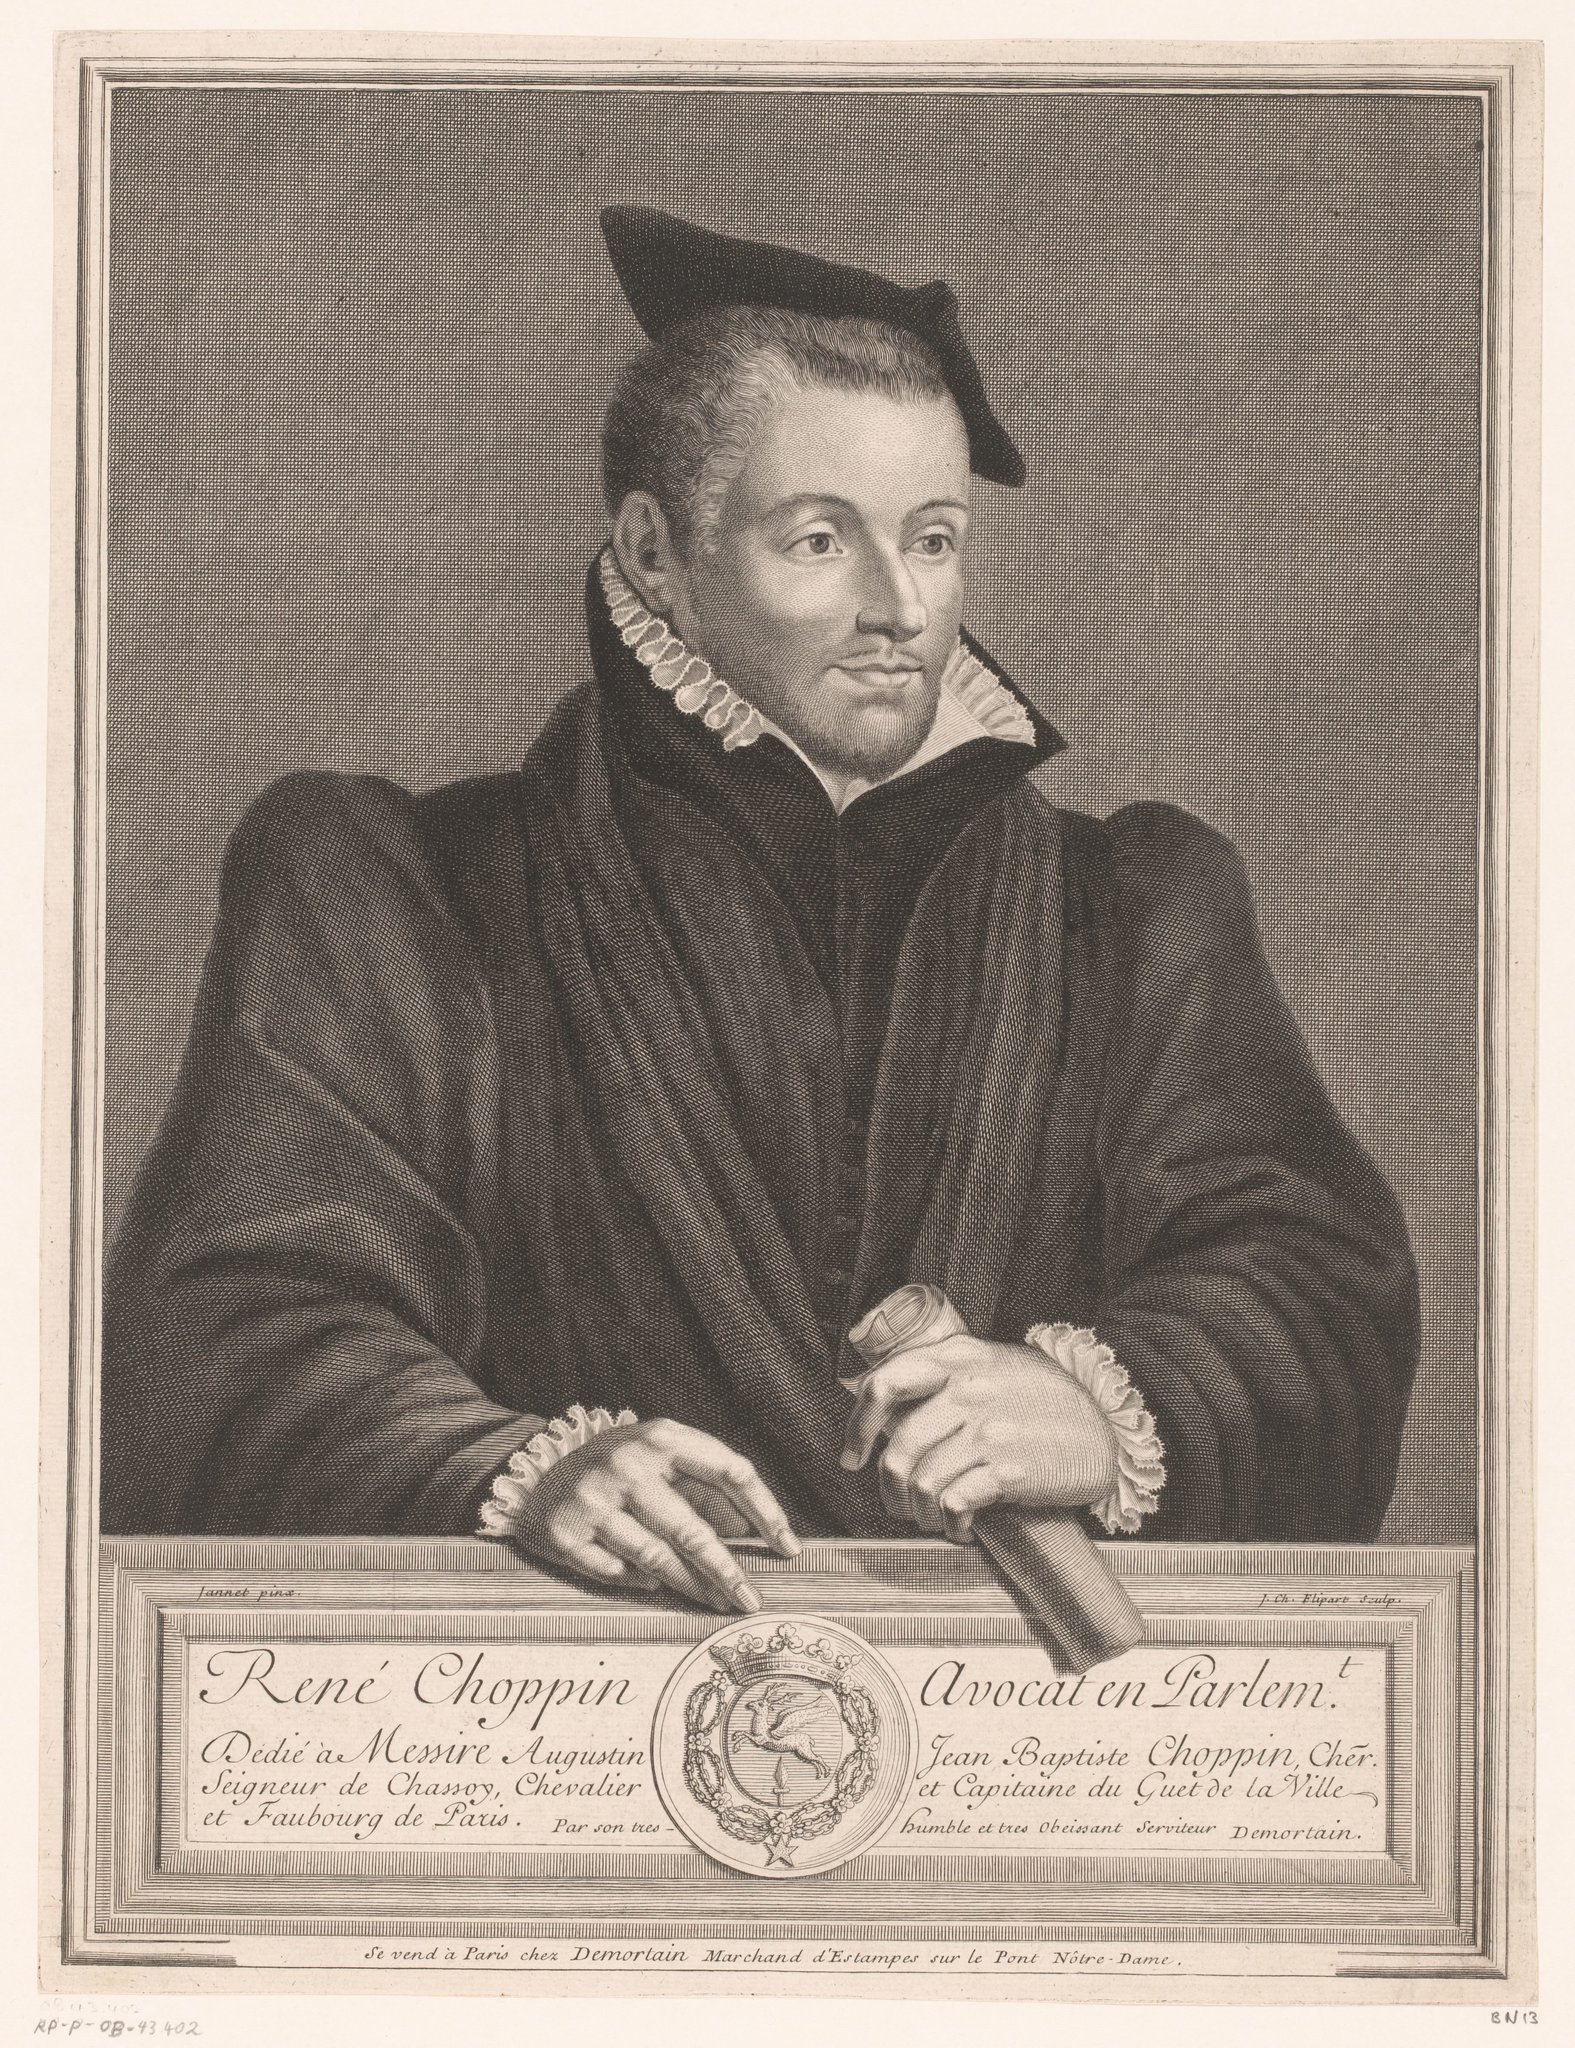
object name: print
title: René Choppin Avocat en Parlem.t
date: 1693-1723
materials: paper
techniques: engraving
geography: paris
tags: paris, historical persons, lawyer, attorney at law, armorial bearing, heraldry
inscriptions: collector's mark: Lugt 2228